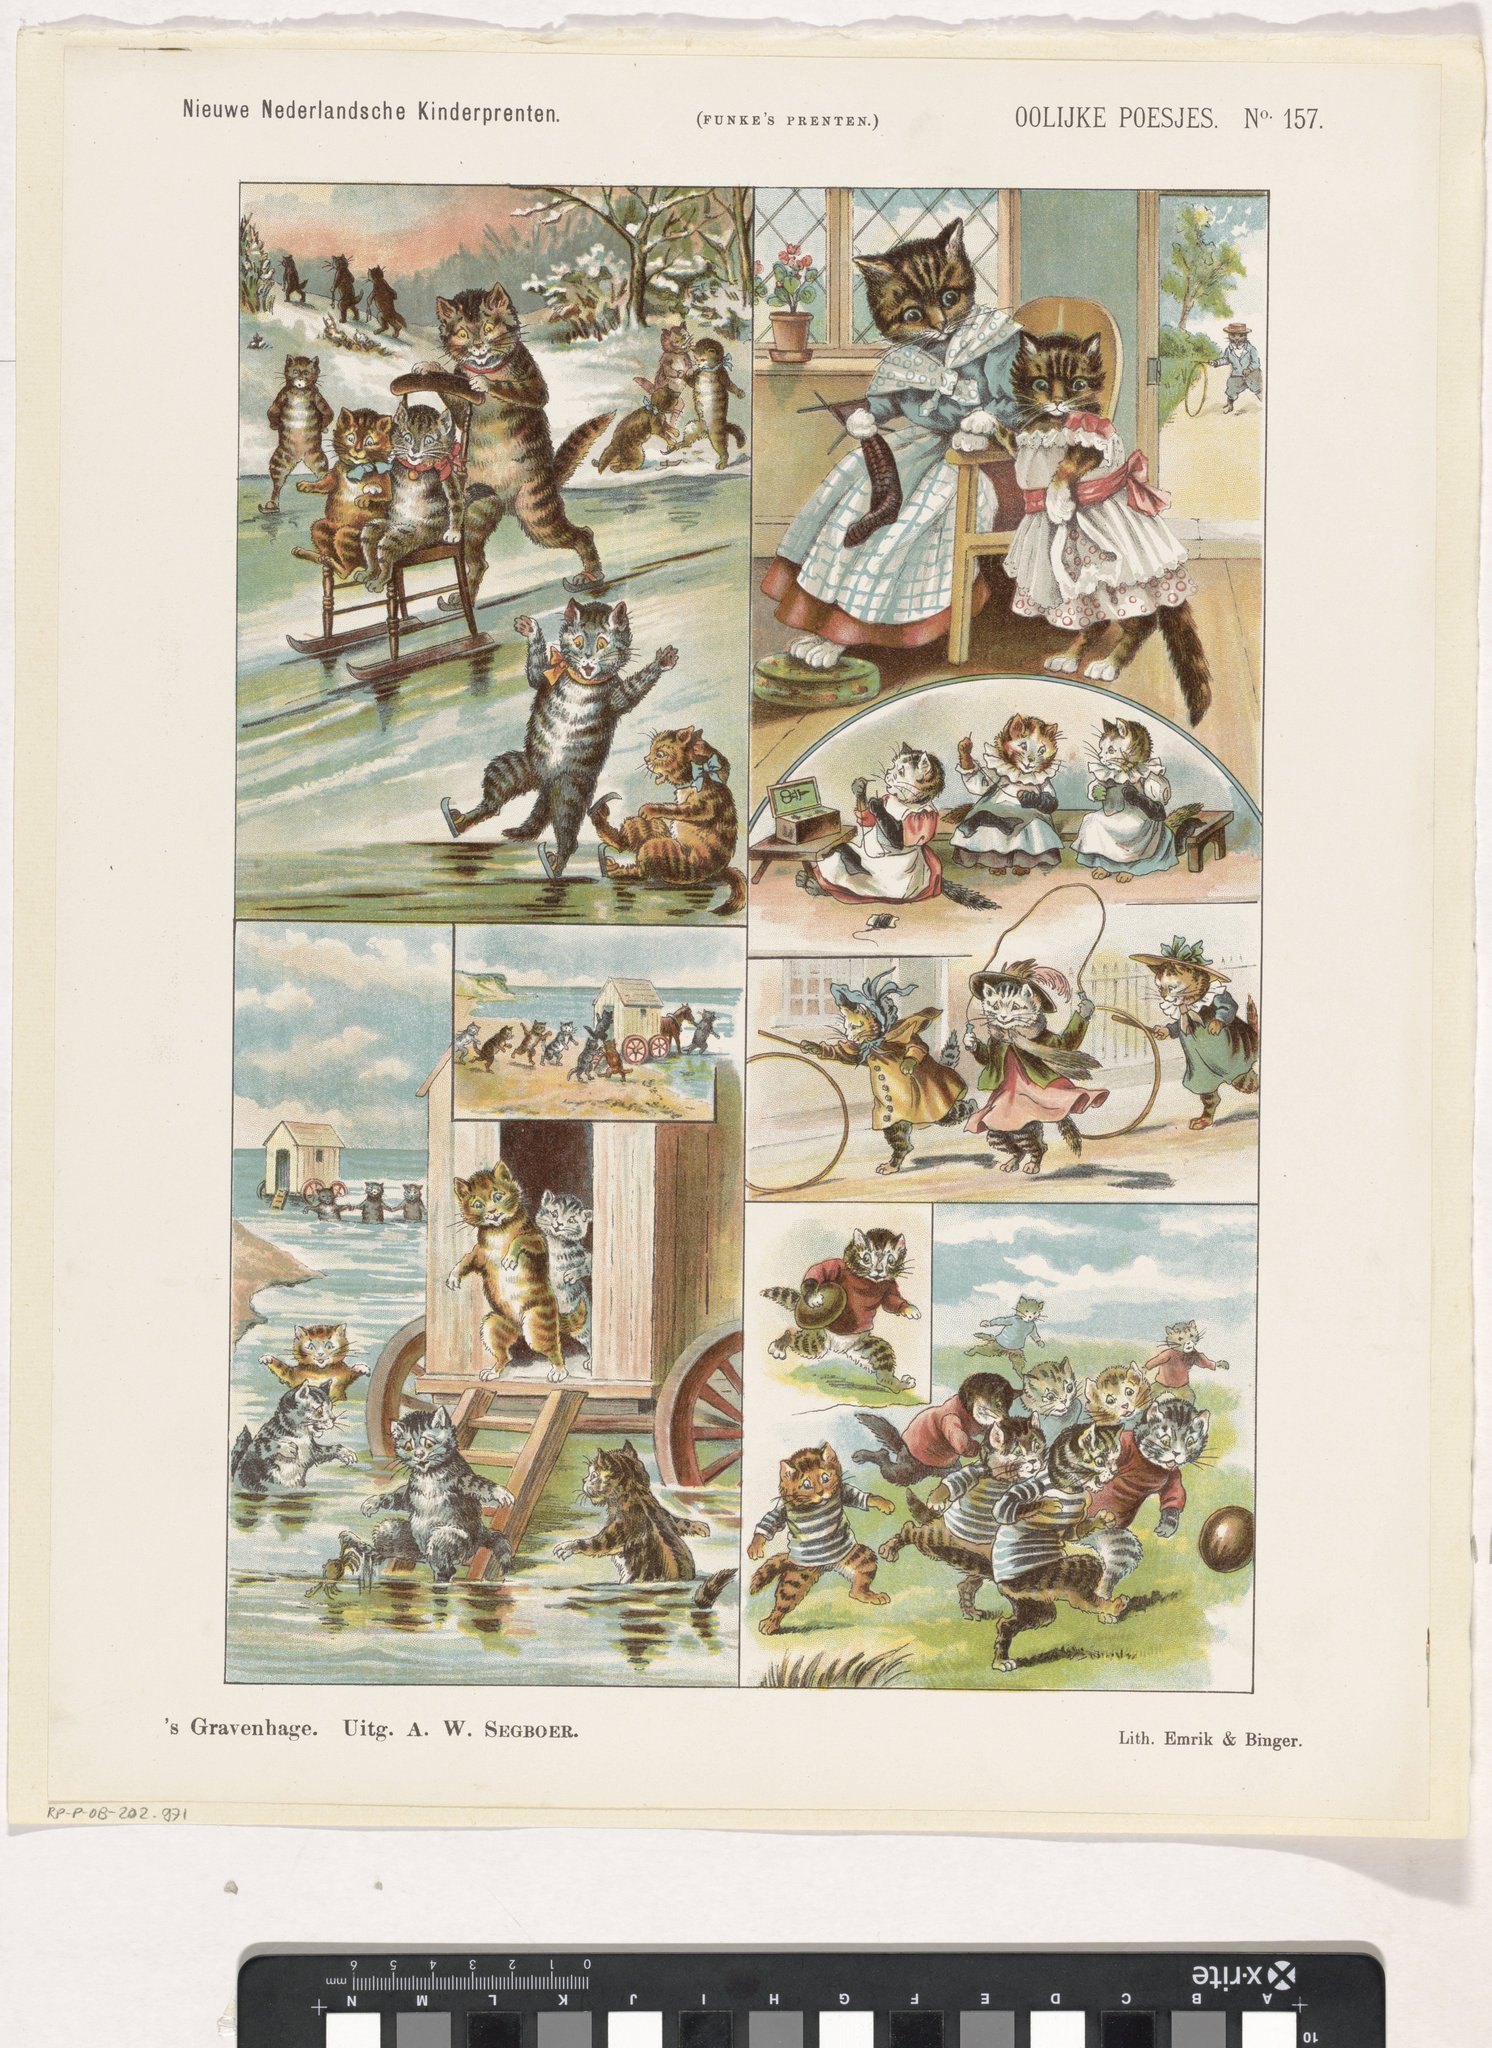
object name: print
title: Funke's prenten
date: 1903-1919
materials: paper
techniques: lithograph, letterpress printing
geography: the hague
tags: cat, animals acting as human beings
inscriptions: collector's mark: Lugt 2760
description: Blad met 8 voorstellingen van poesjes die zich als mensen gedragen, waaronder poesjes die schaatsen, poesjes die hoepelen en poesjes die voetballen. Genummerd rechtsboven: No. 157.